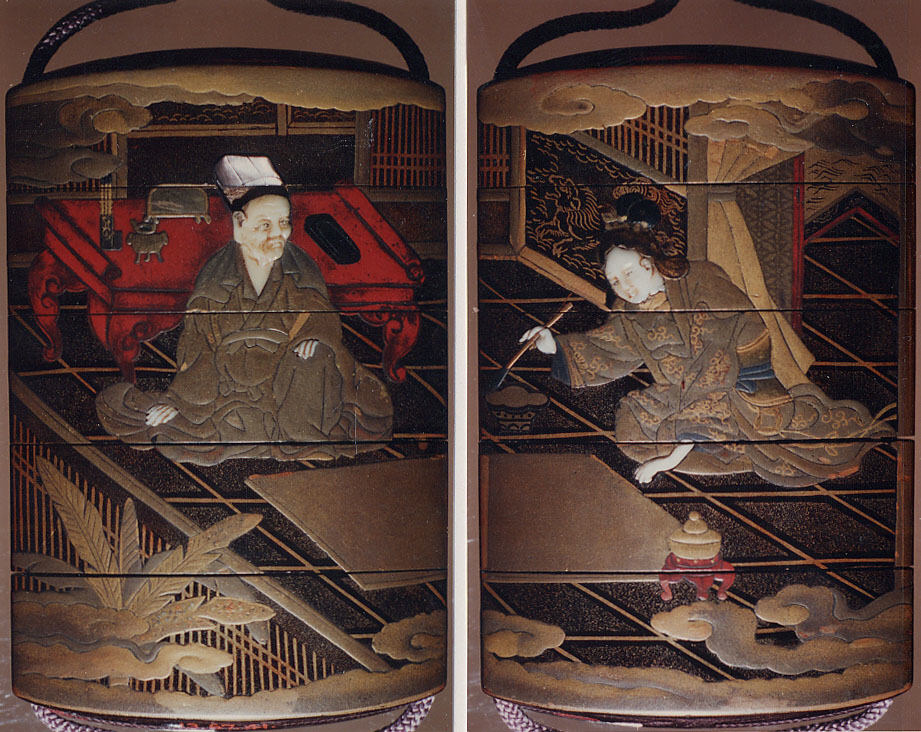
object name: inrō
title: Case (Inrō) with Design of Chinese Scholar Seated at Low Desk (obverse); Lady Using Brush (reverse)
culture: japanese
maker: hasensai senjin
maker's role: artist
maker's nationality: japanese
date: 1801-1900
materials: coral, ivory, lacquer, mother of pearl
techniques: carving, hiramakie, inlay, polish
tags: painting,men,women,desks,brushes